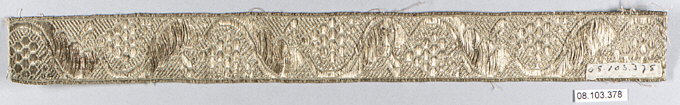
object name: galloon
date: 1601-1800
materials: metal thread